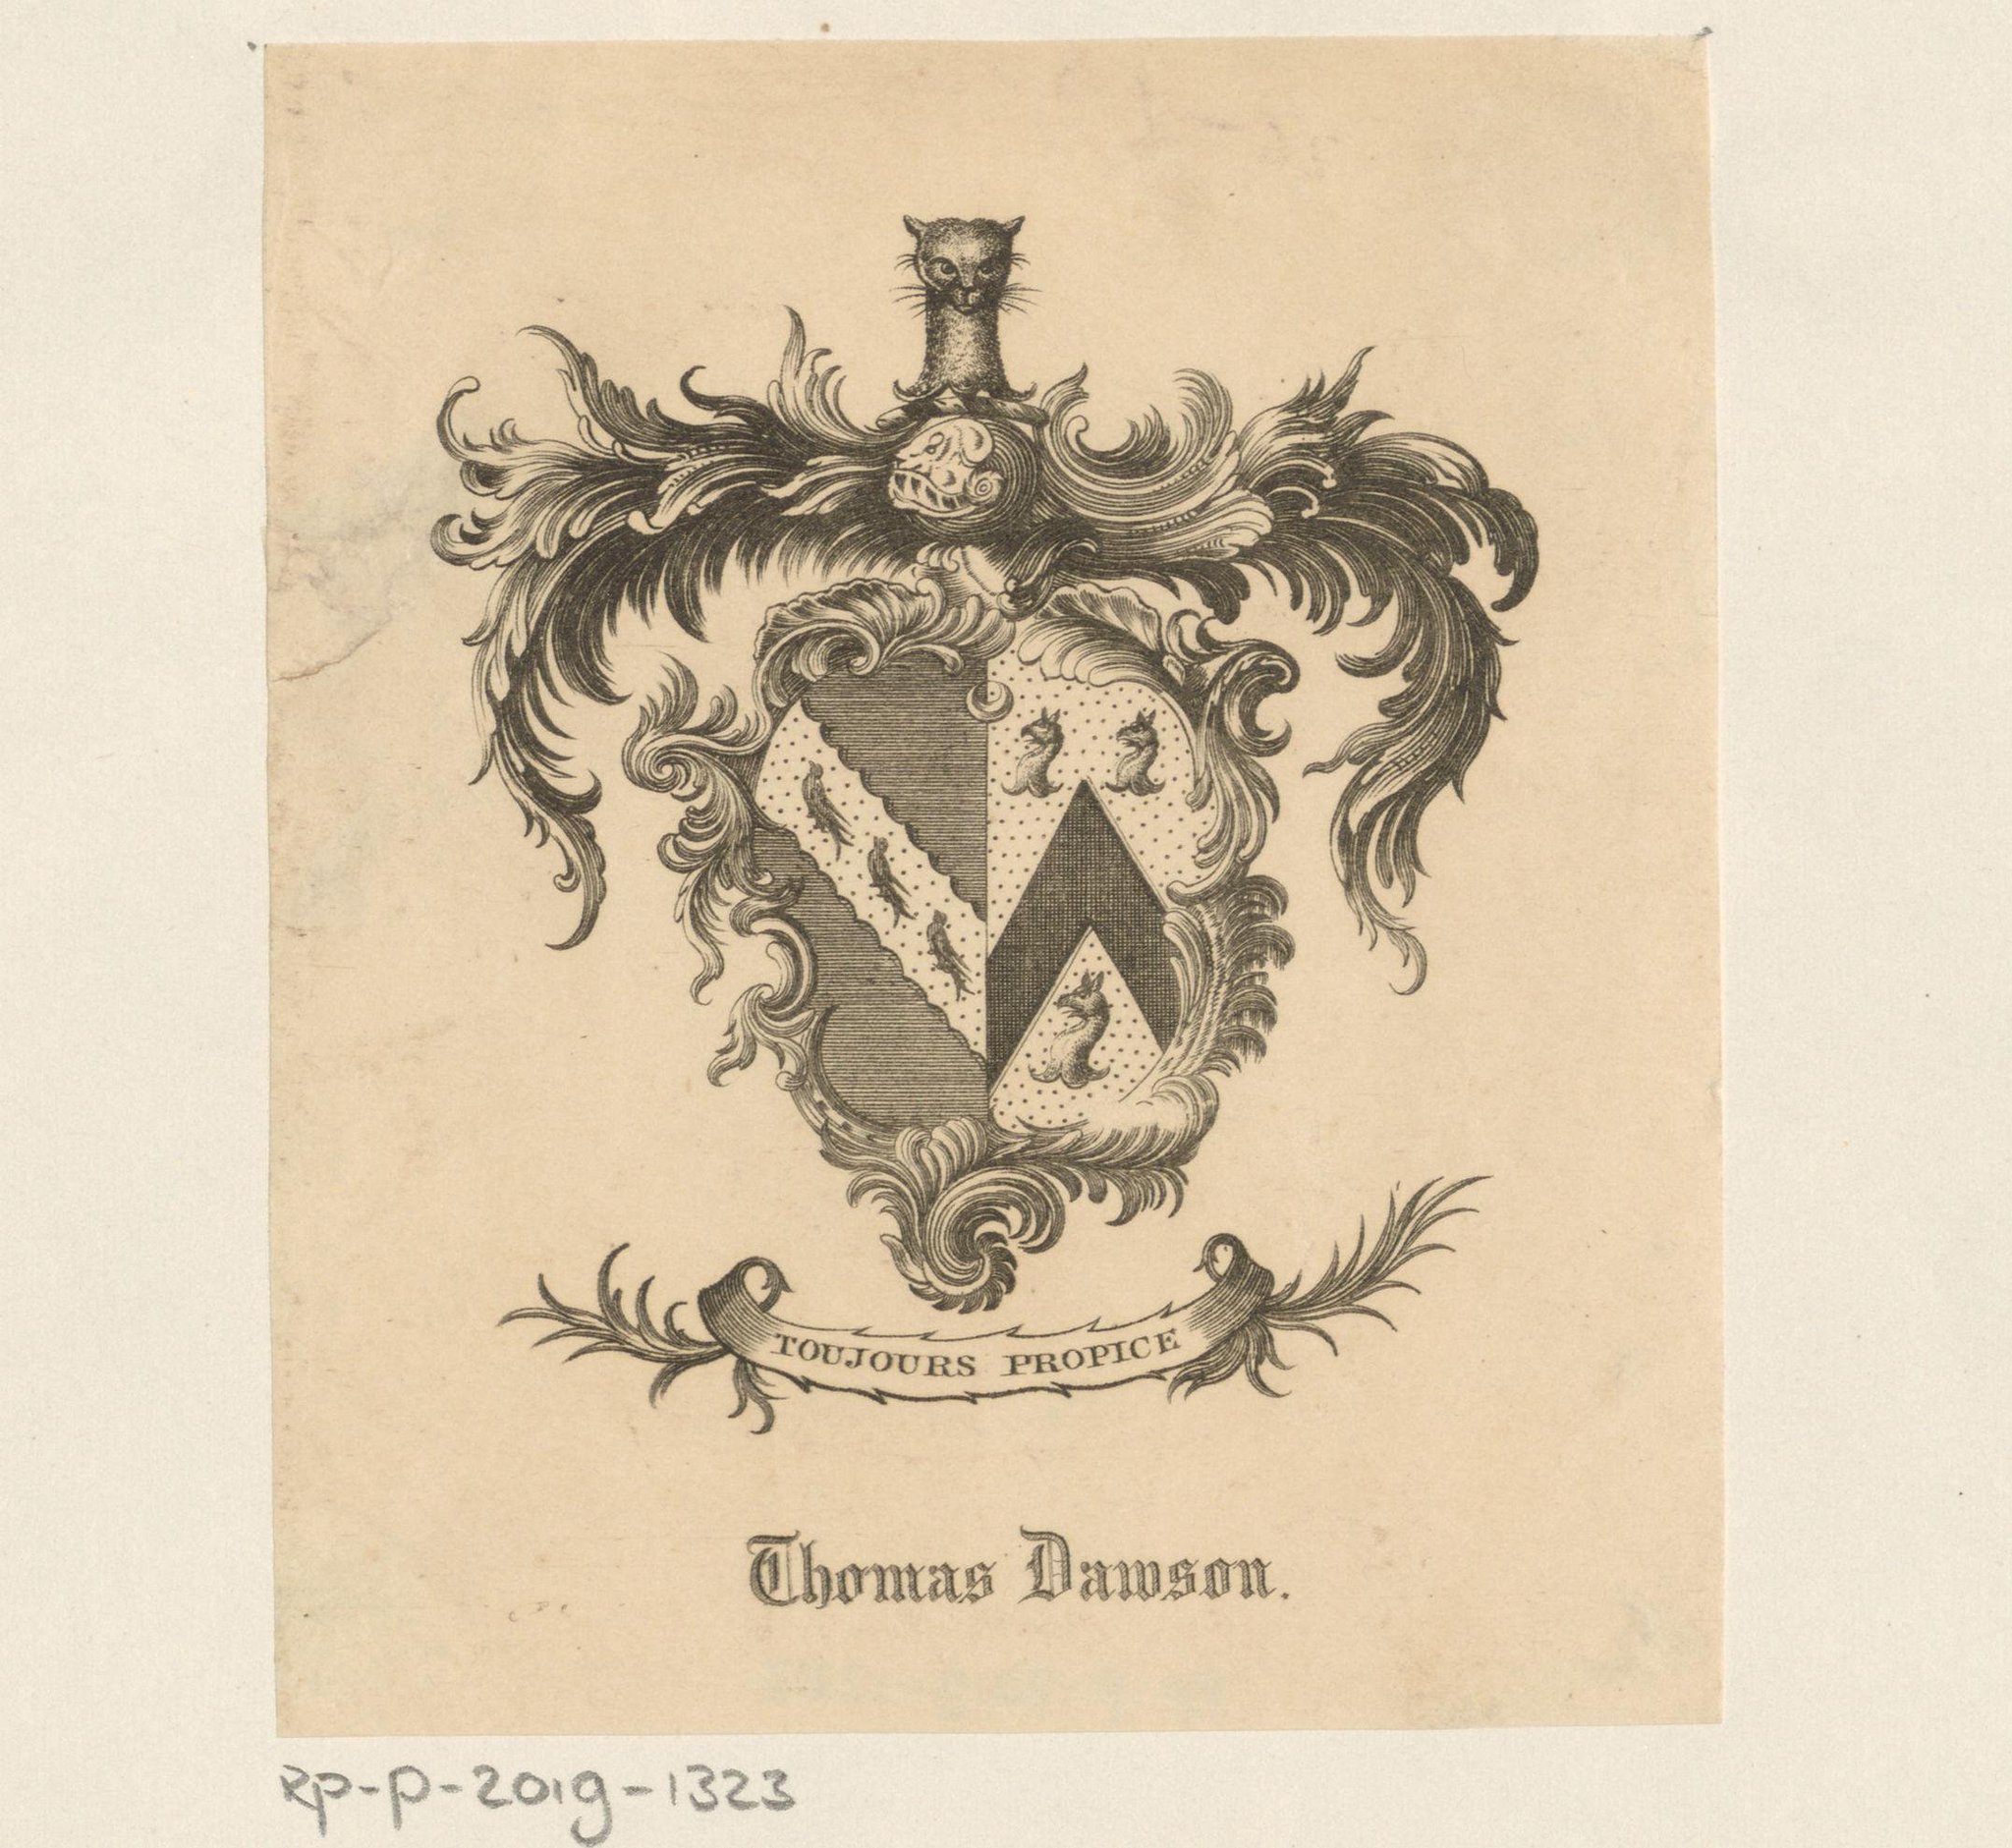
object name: bookplate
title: Ex libris van Thomas Dawson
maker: Anonymous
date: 1800-1899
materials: paper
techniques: engraving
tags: armorial bearing, heraldry